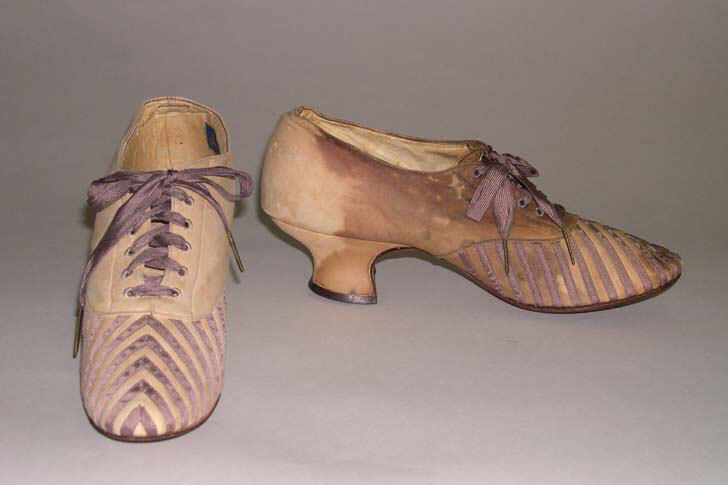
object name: slipper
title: Slippers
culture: american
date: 1880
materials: leather, silk